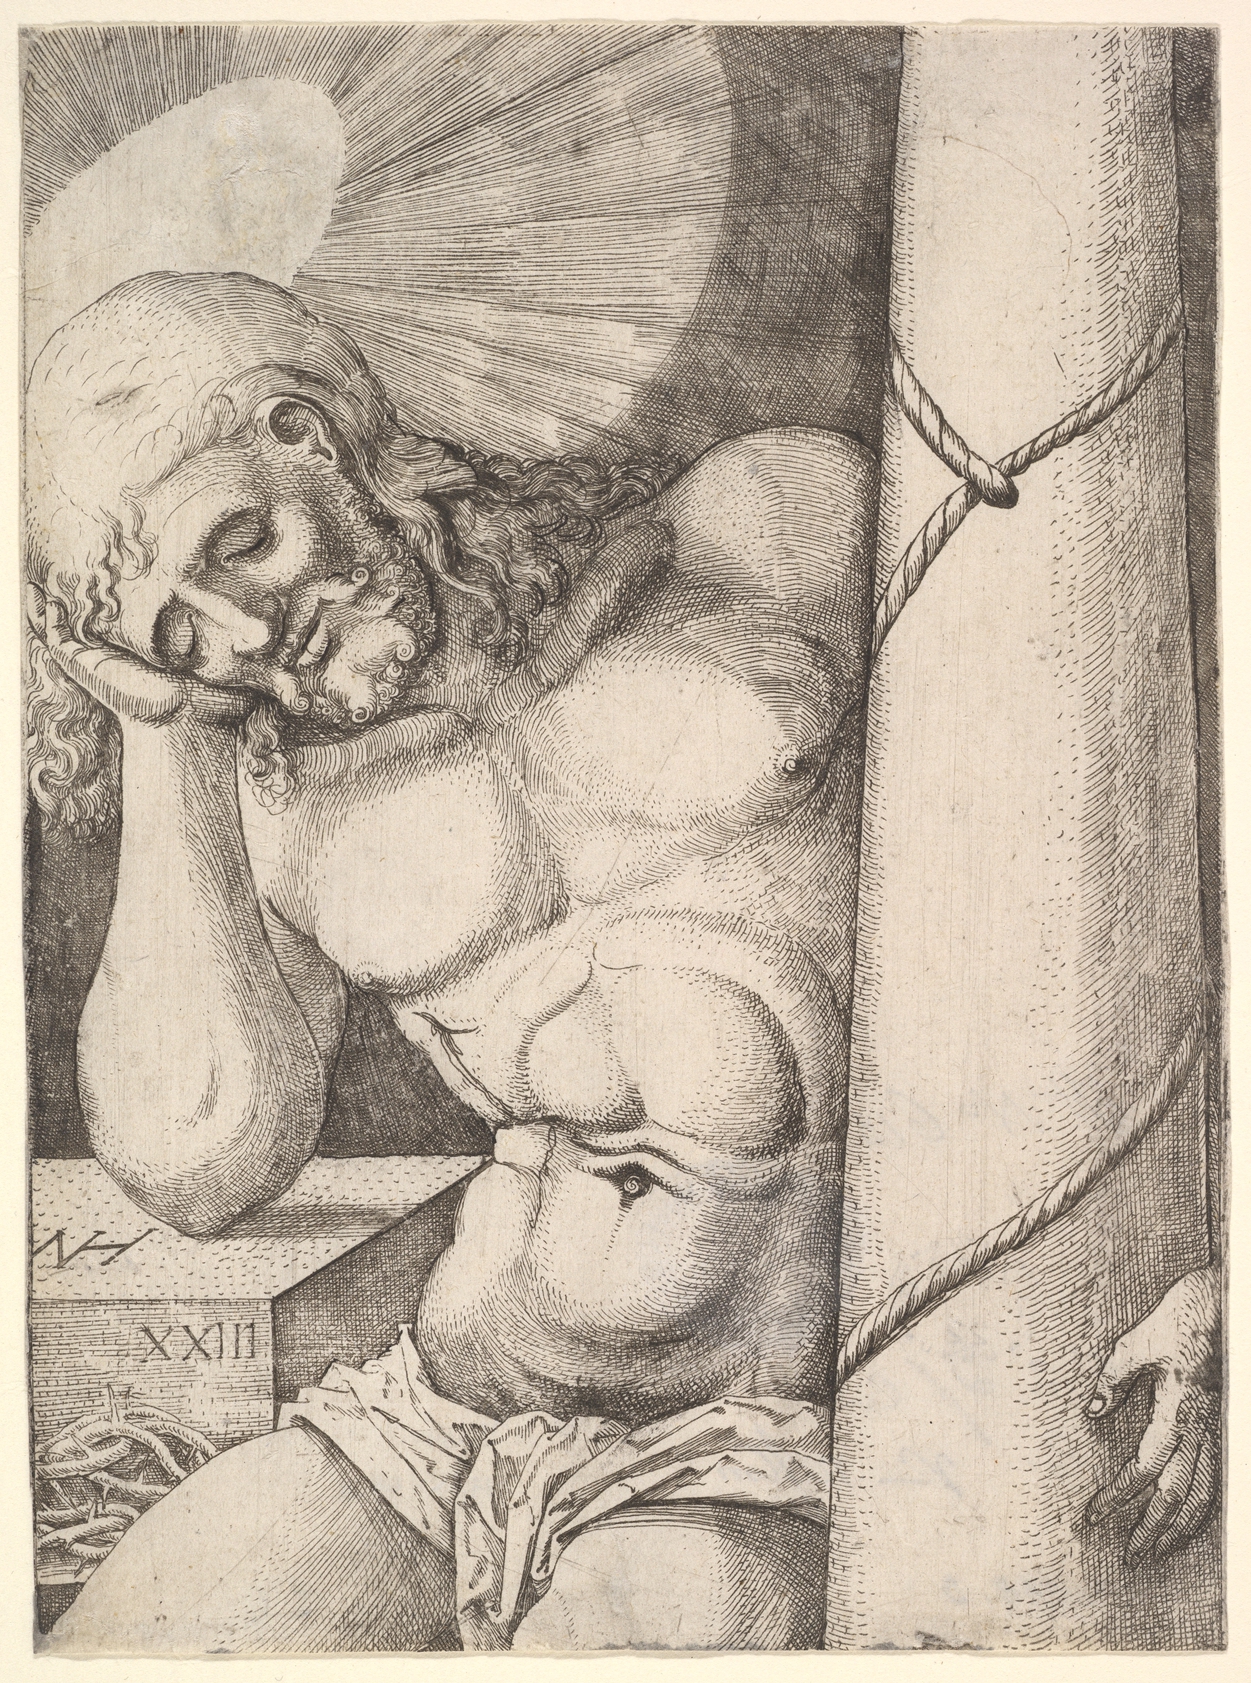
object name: print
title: The Man of Sorrows at the Column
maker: nicolaas hogenberg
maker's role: draughtsman, painter, print maker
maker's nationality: netherlandish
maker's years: 1500-1539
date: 1523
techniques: etching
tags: sadness,christ